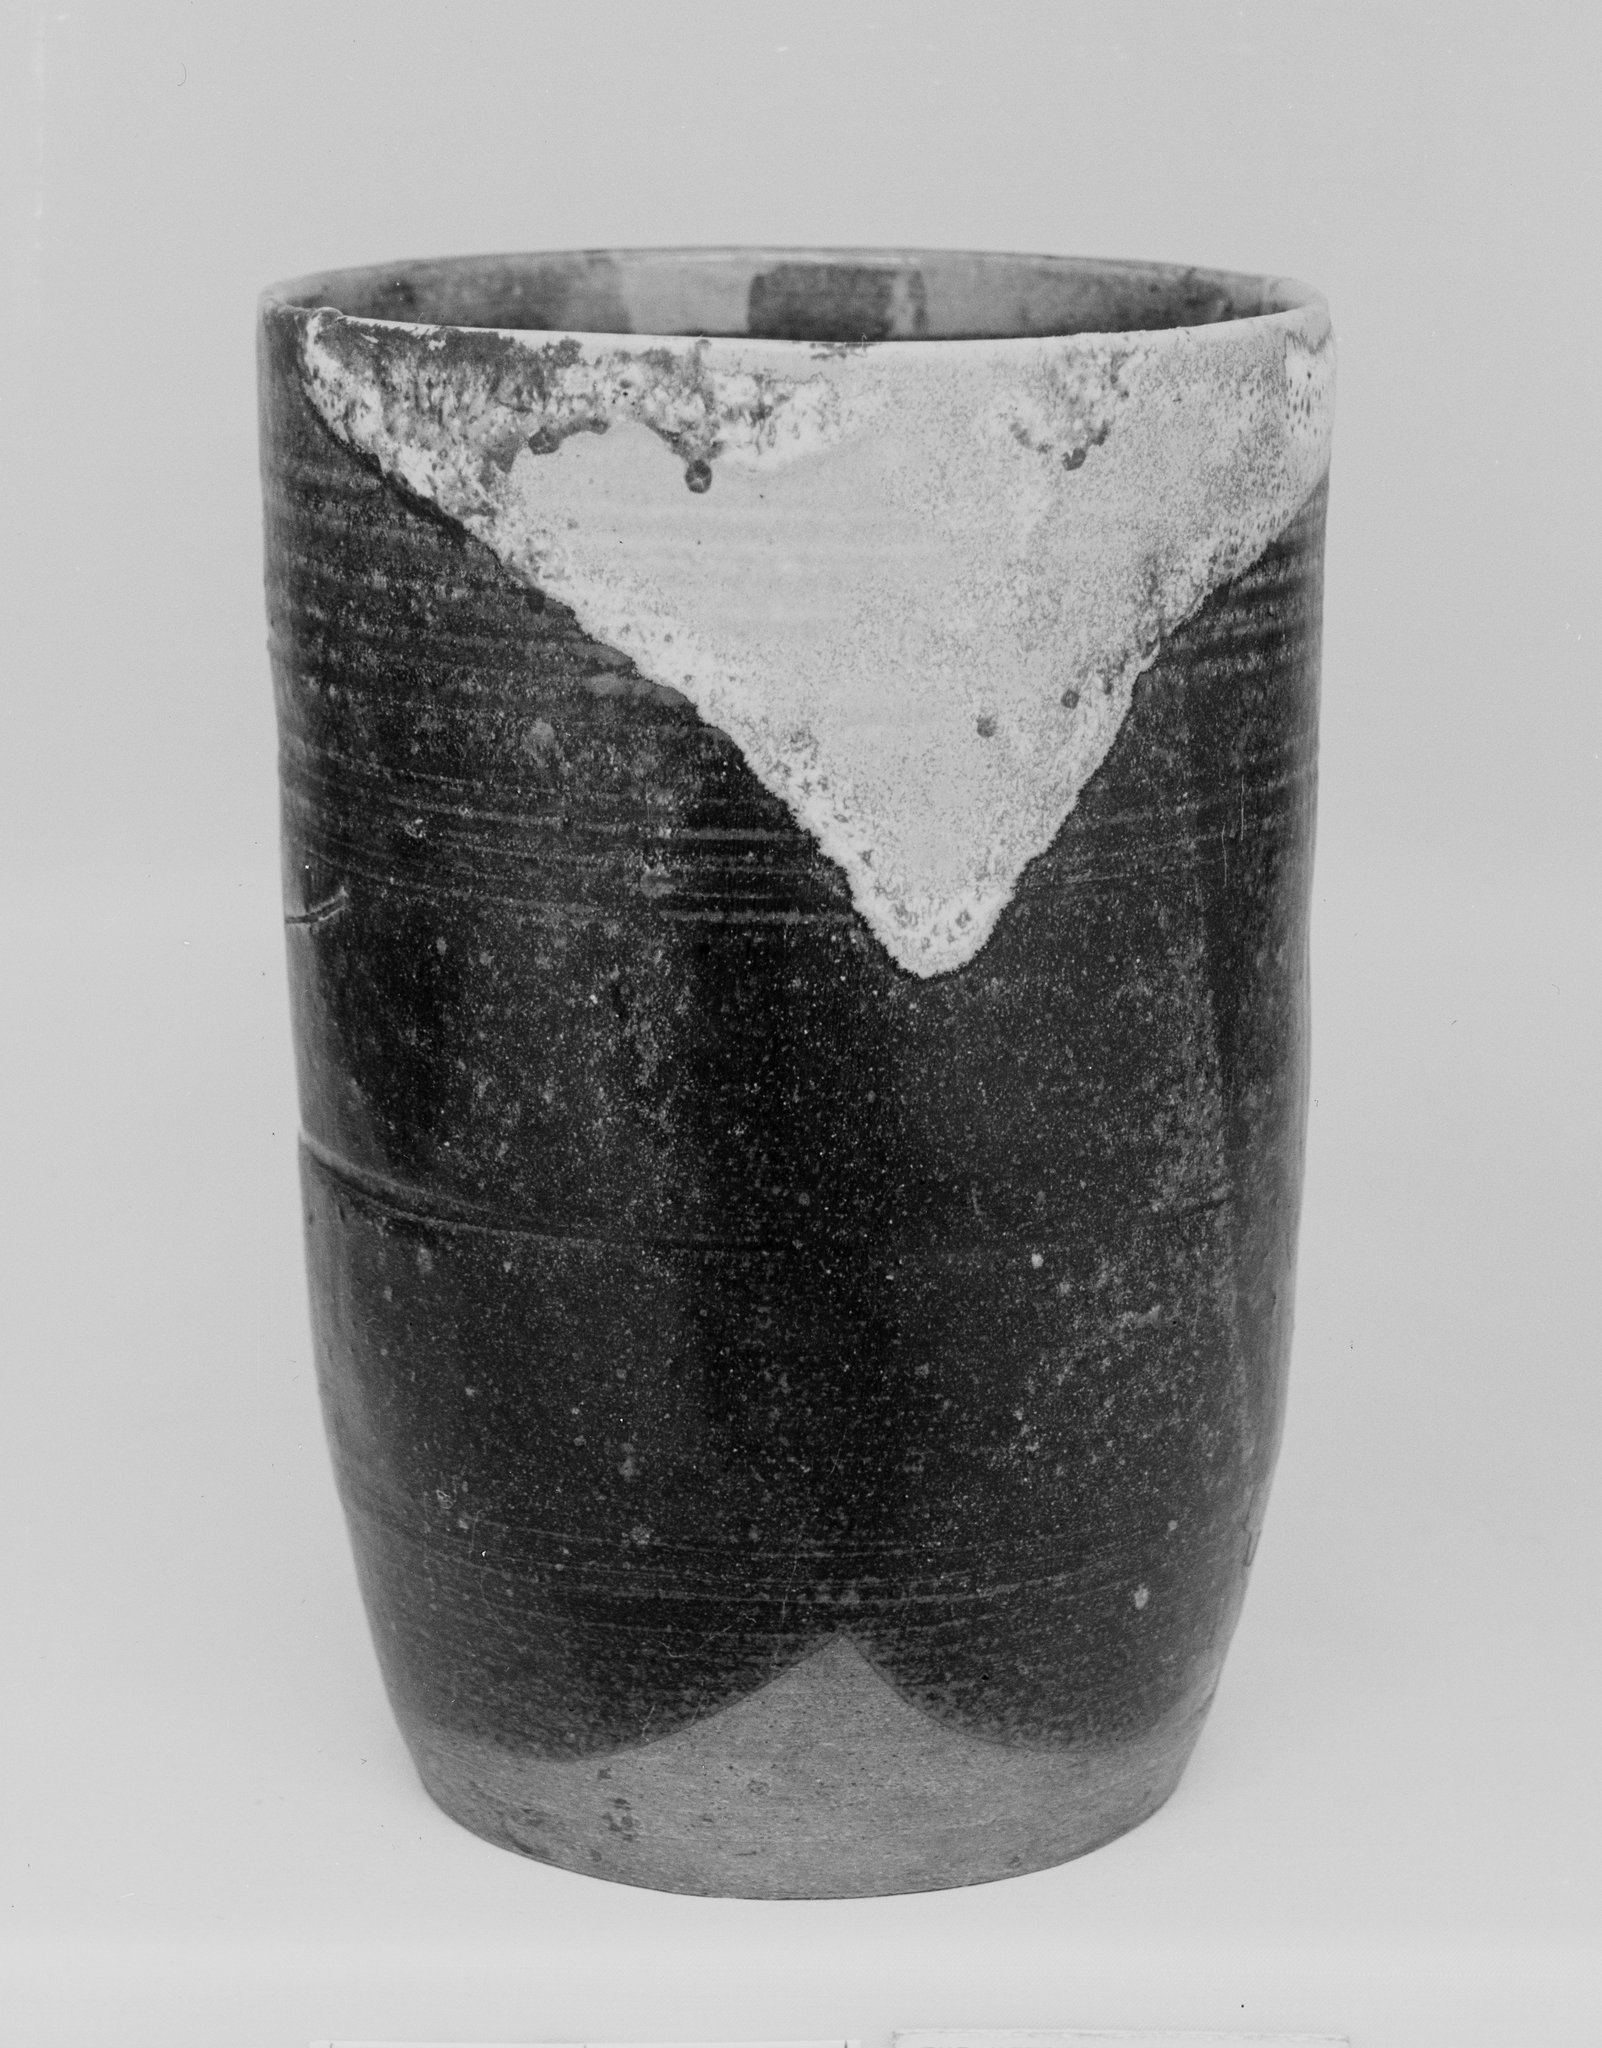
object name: water pot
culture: japanese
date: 1701-1800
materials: clay, glaze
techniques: overglaze